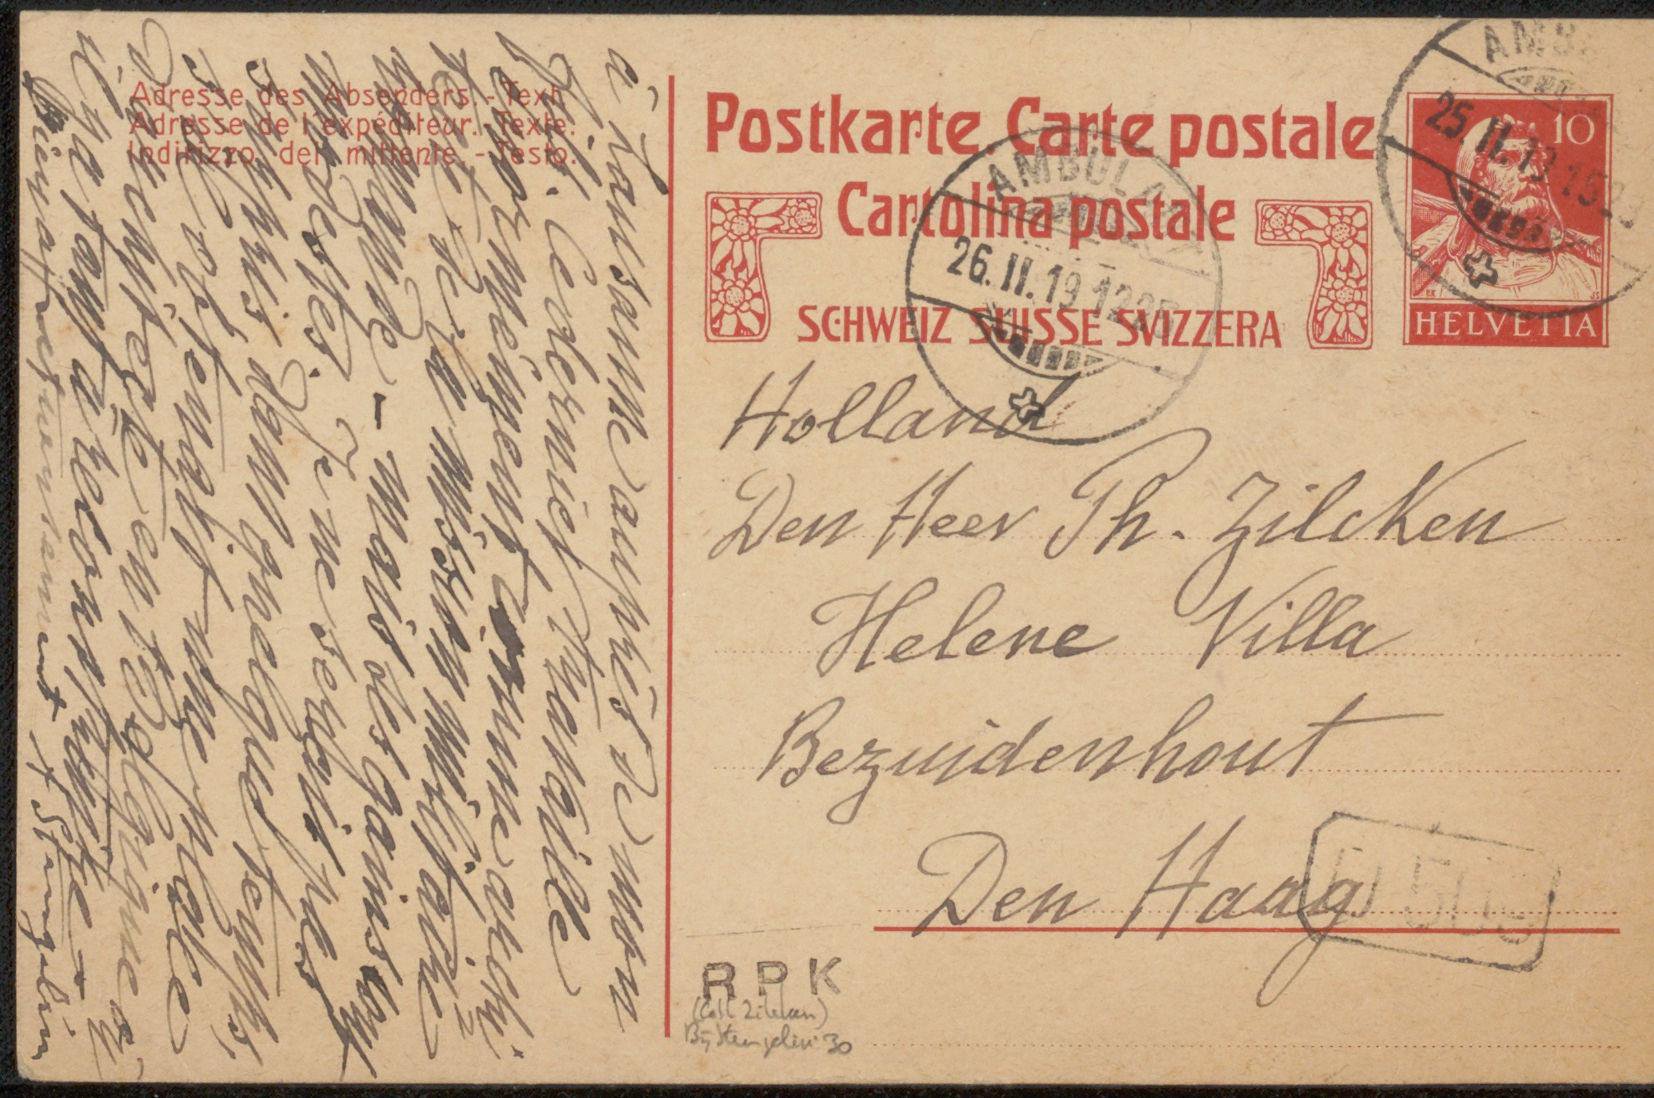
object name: postcard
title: Briefkaart aan Philip Zilcken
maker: alphonse stengelin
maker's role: painter, print maker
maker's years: 1852-1938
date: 1919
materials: cardboard, ink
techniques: pen, writing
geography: satigny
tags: the hague, draughtsman, philip zilcken, family life, architecture, diseases, switzerland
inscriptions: collector's mark: ‘RPK’